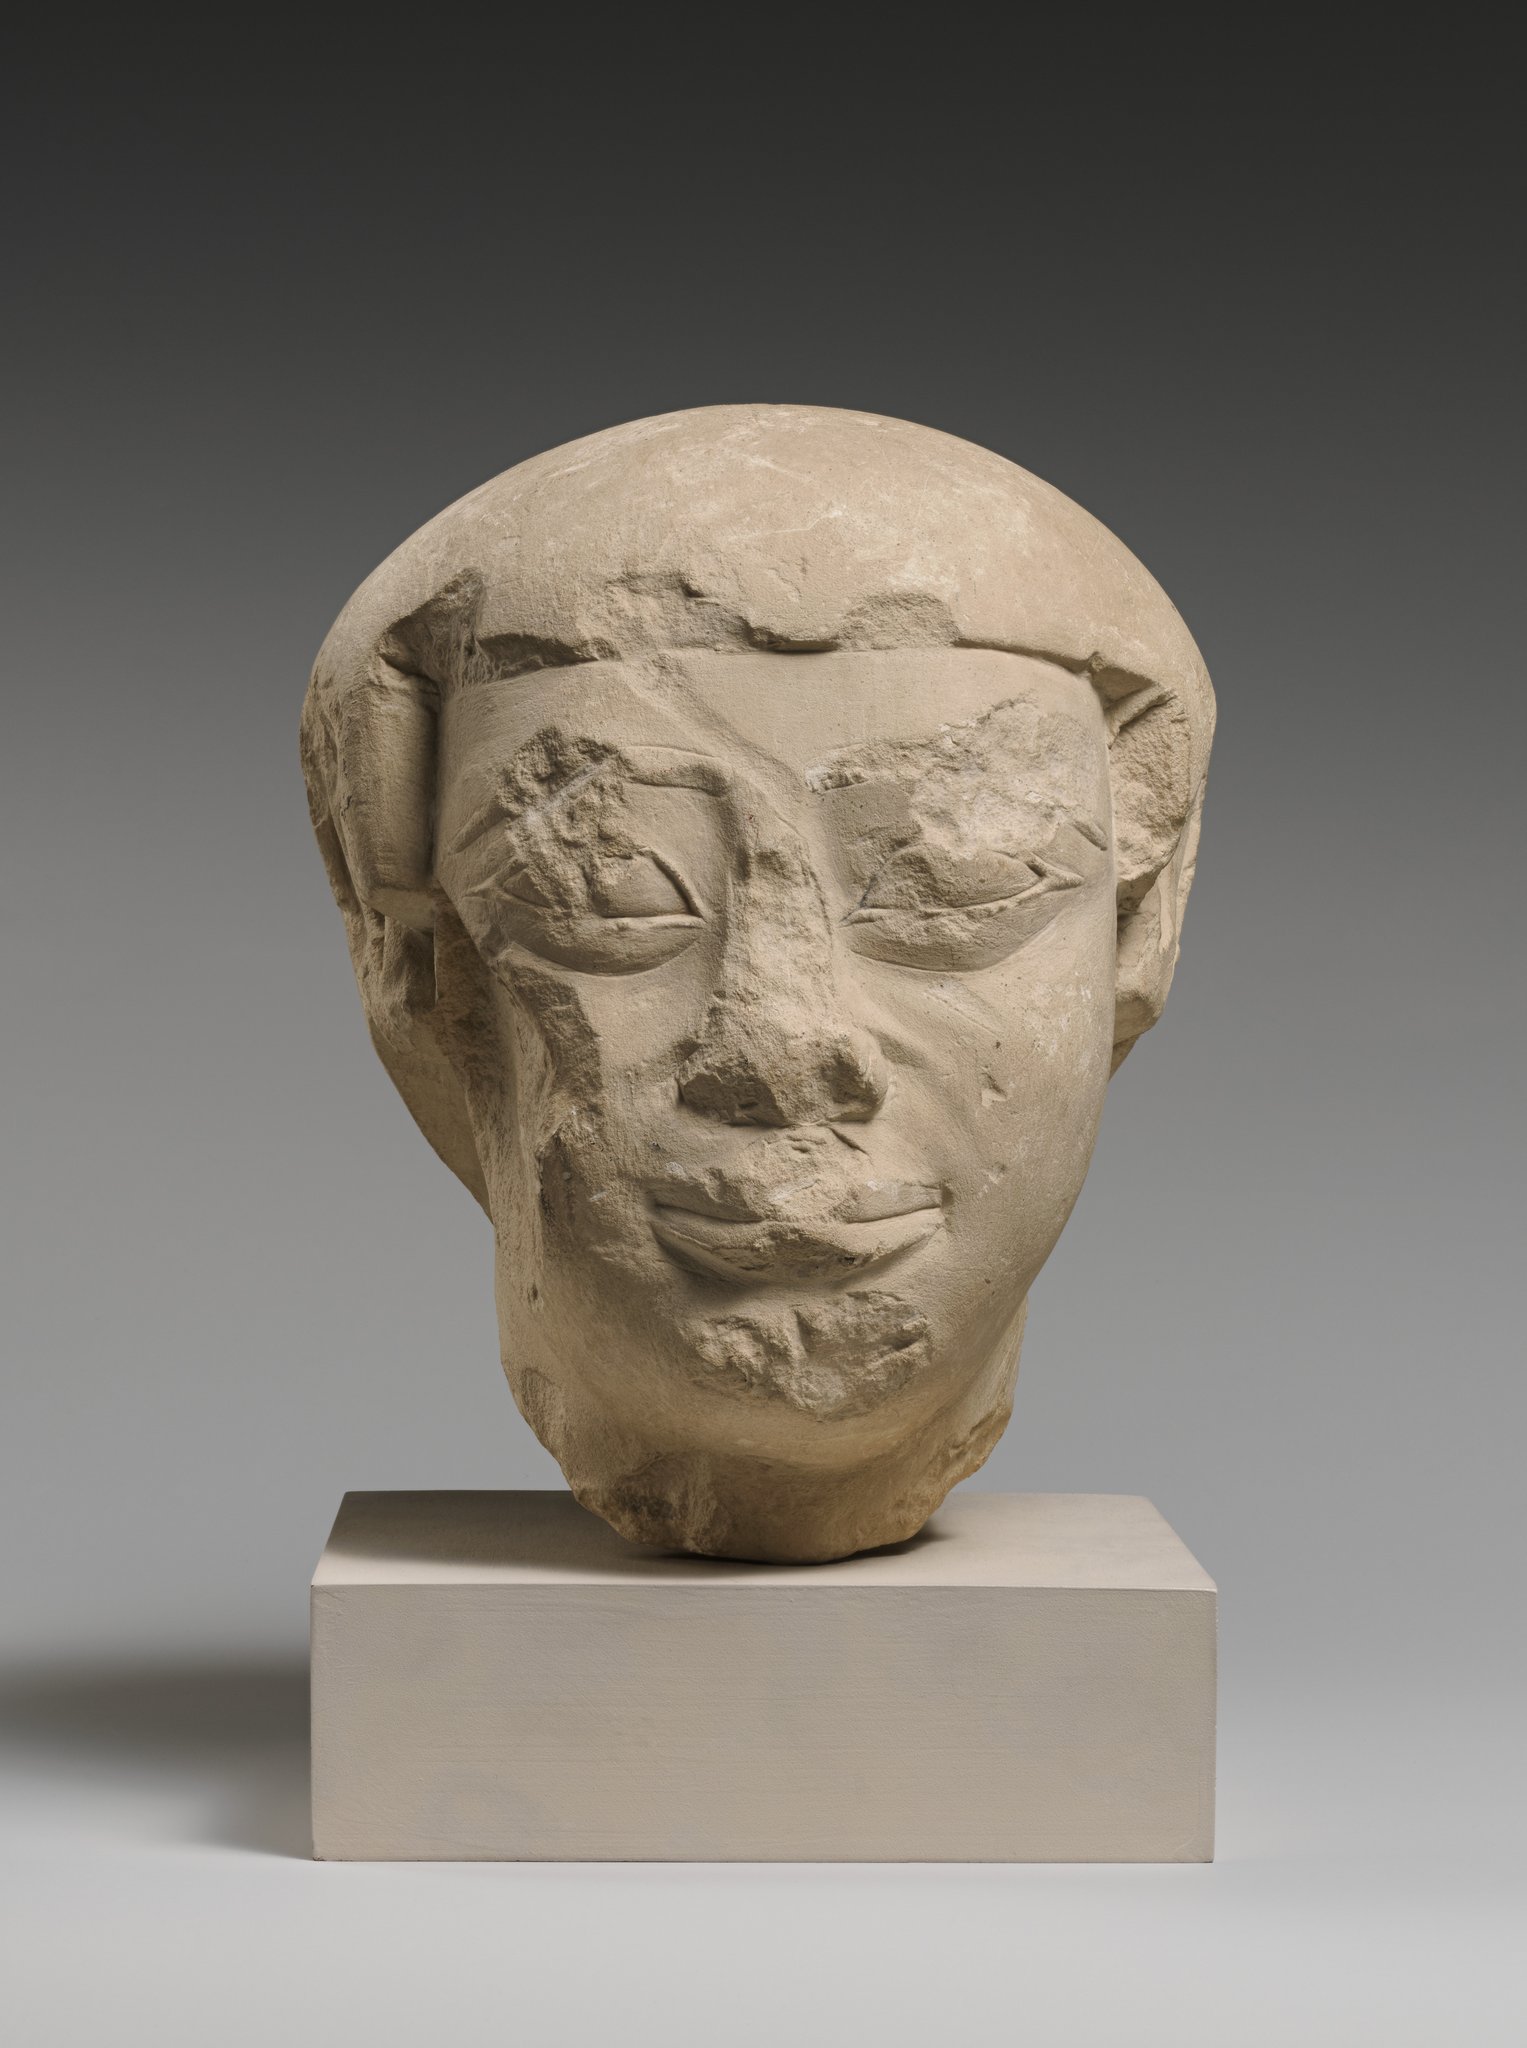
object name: head, male statue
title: Head of statue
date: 1981-1950 BCE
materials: limestone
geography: egypt